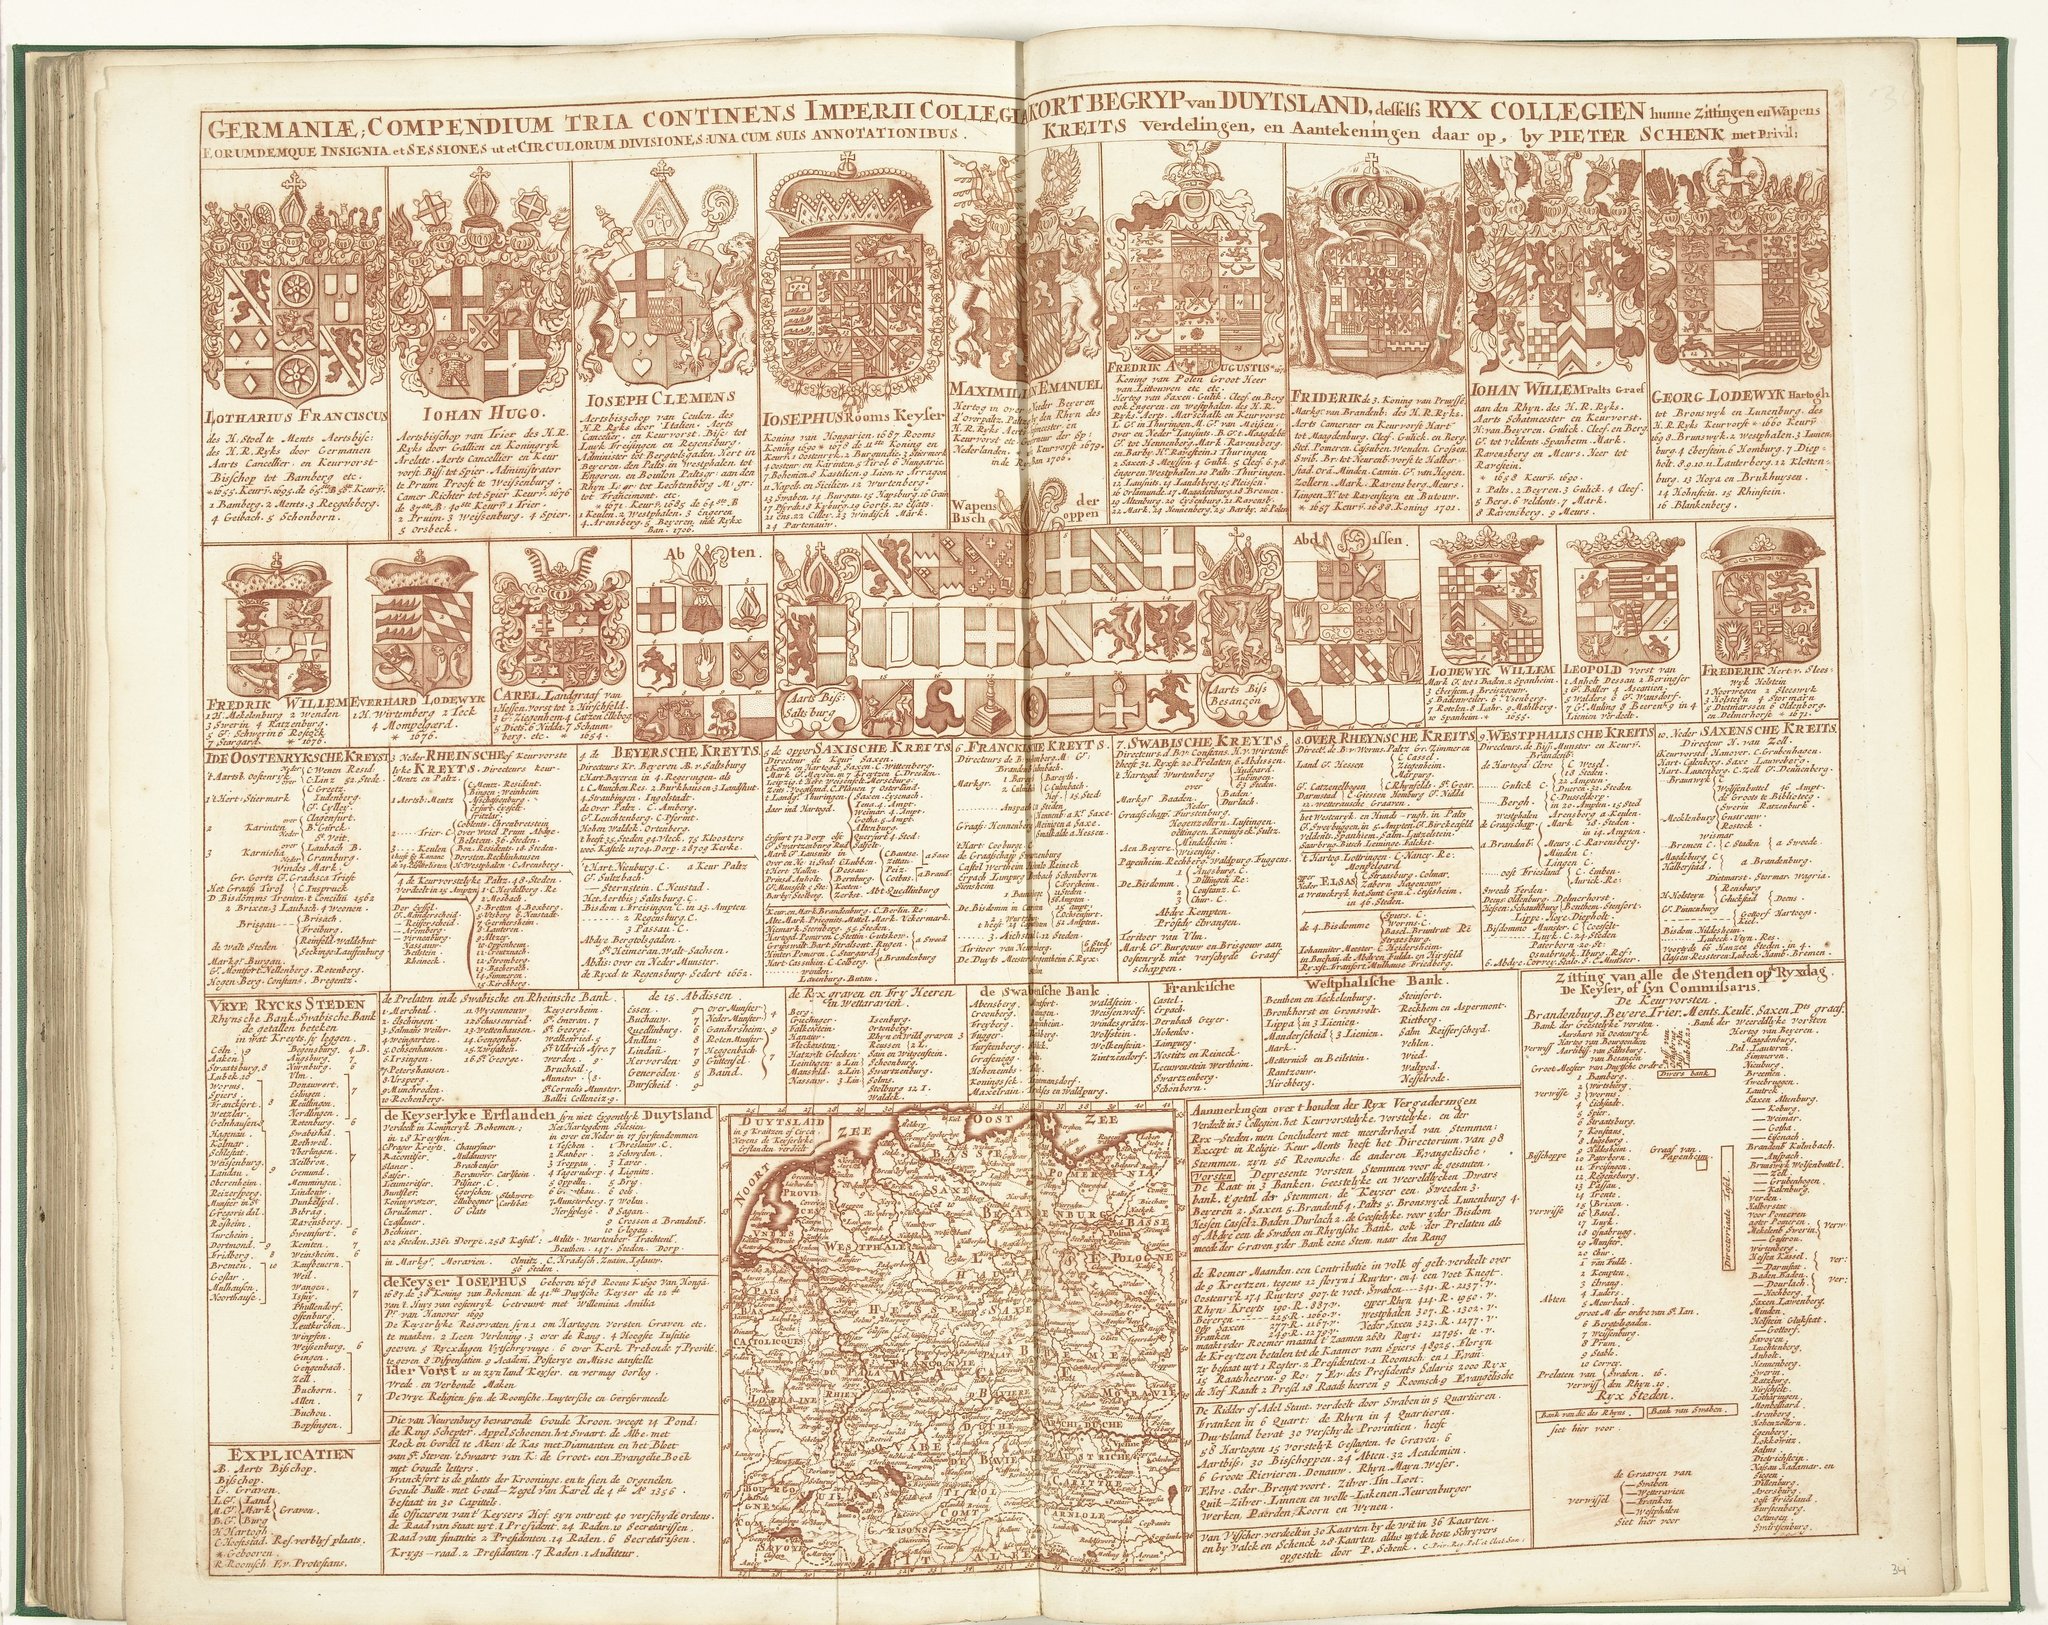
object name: print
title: Schouwburg van den oorlog (blad XXXIV), ca. 1705-1710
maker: pieter schenk (i)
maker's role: print maker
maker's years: 1660-1711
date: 1705-1710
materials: paper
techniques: etching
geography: amsterdam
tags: jozef i (duits keizer), weapons, germany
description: Blad met de wapens van Duitse vorsten, lijsten van de kreitsen, rijkssteden, kaartje van Duitsland, etc. Opschriften in de voorstelling in het Nederlands. Blad XXXIV in: Schouwburg van den oorlog (editie van 1720), het prentwerk met de gebundelde reeks van 31 platen over de Spaanse Successieoorlog.